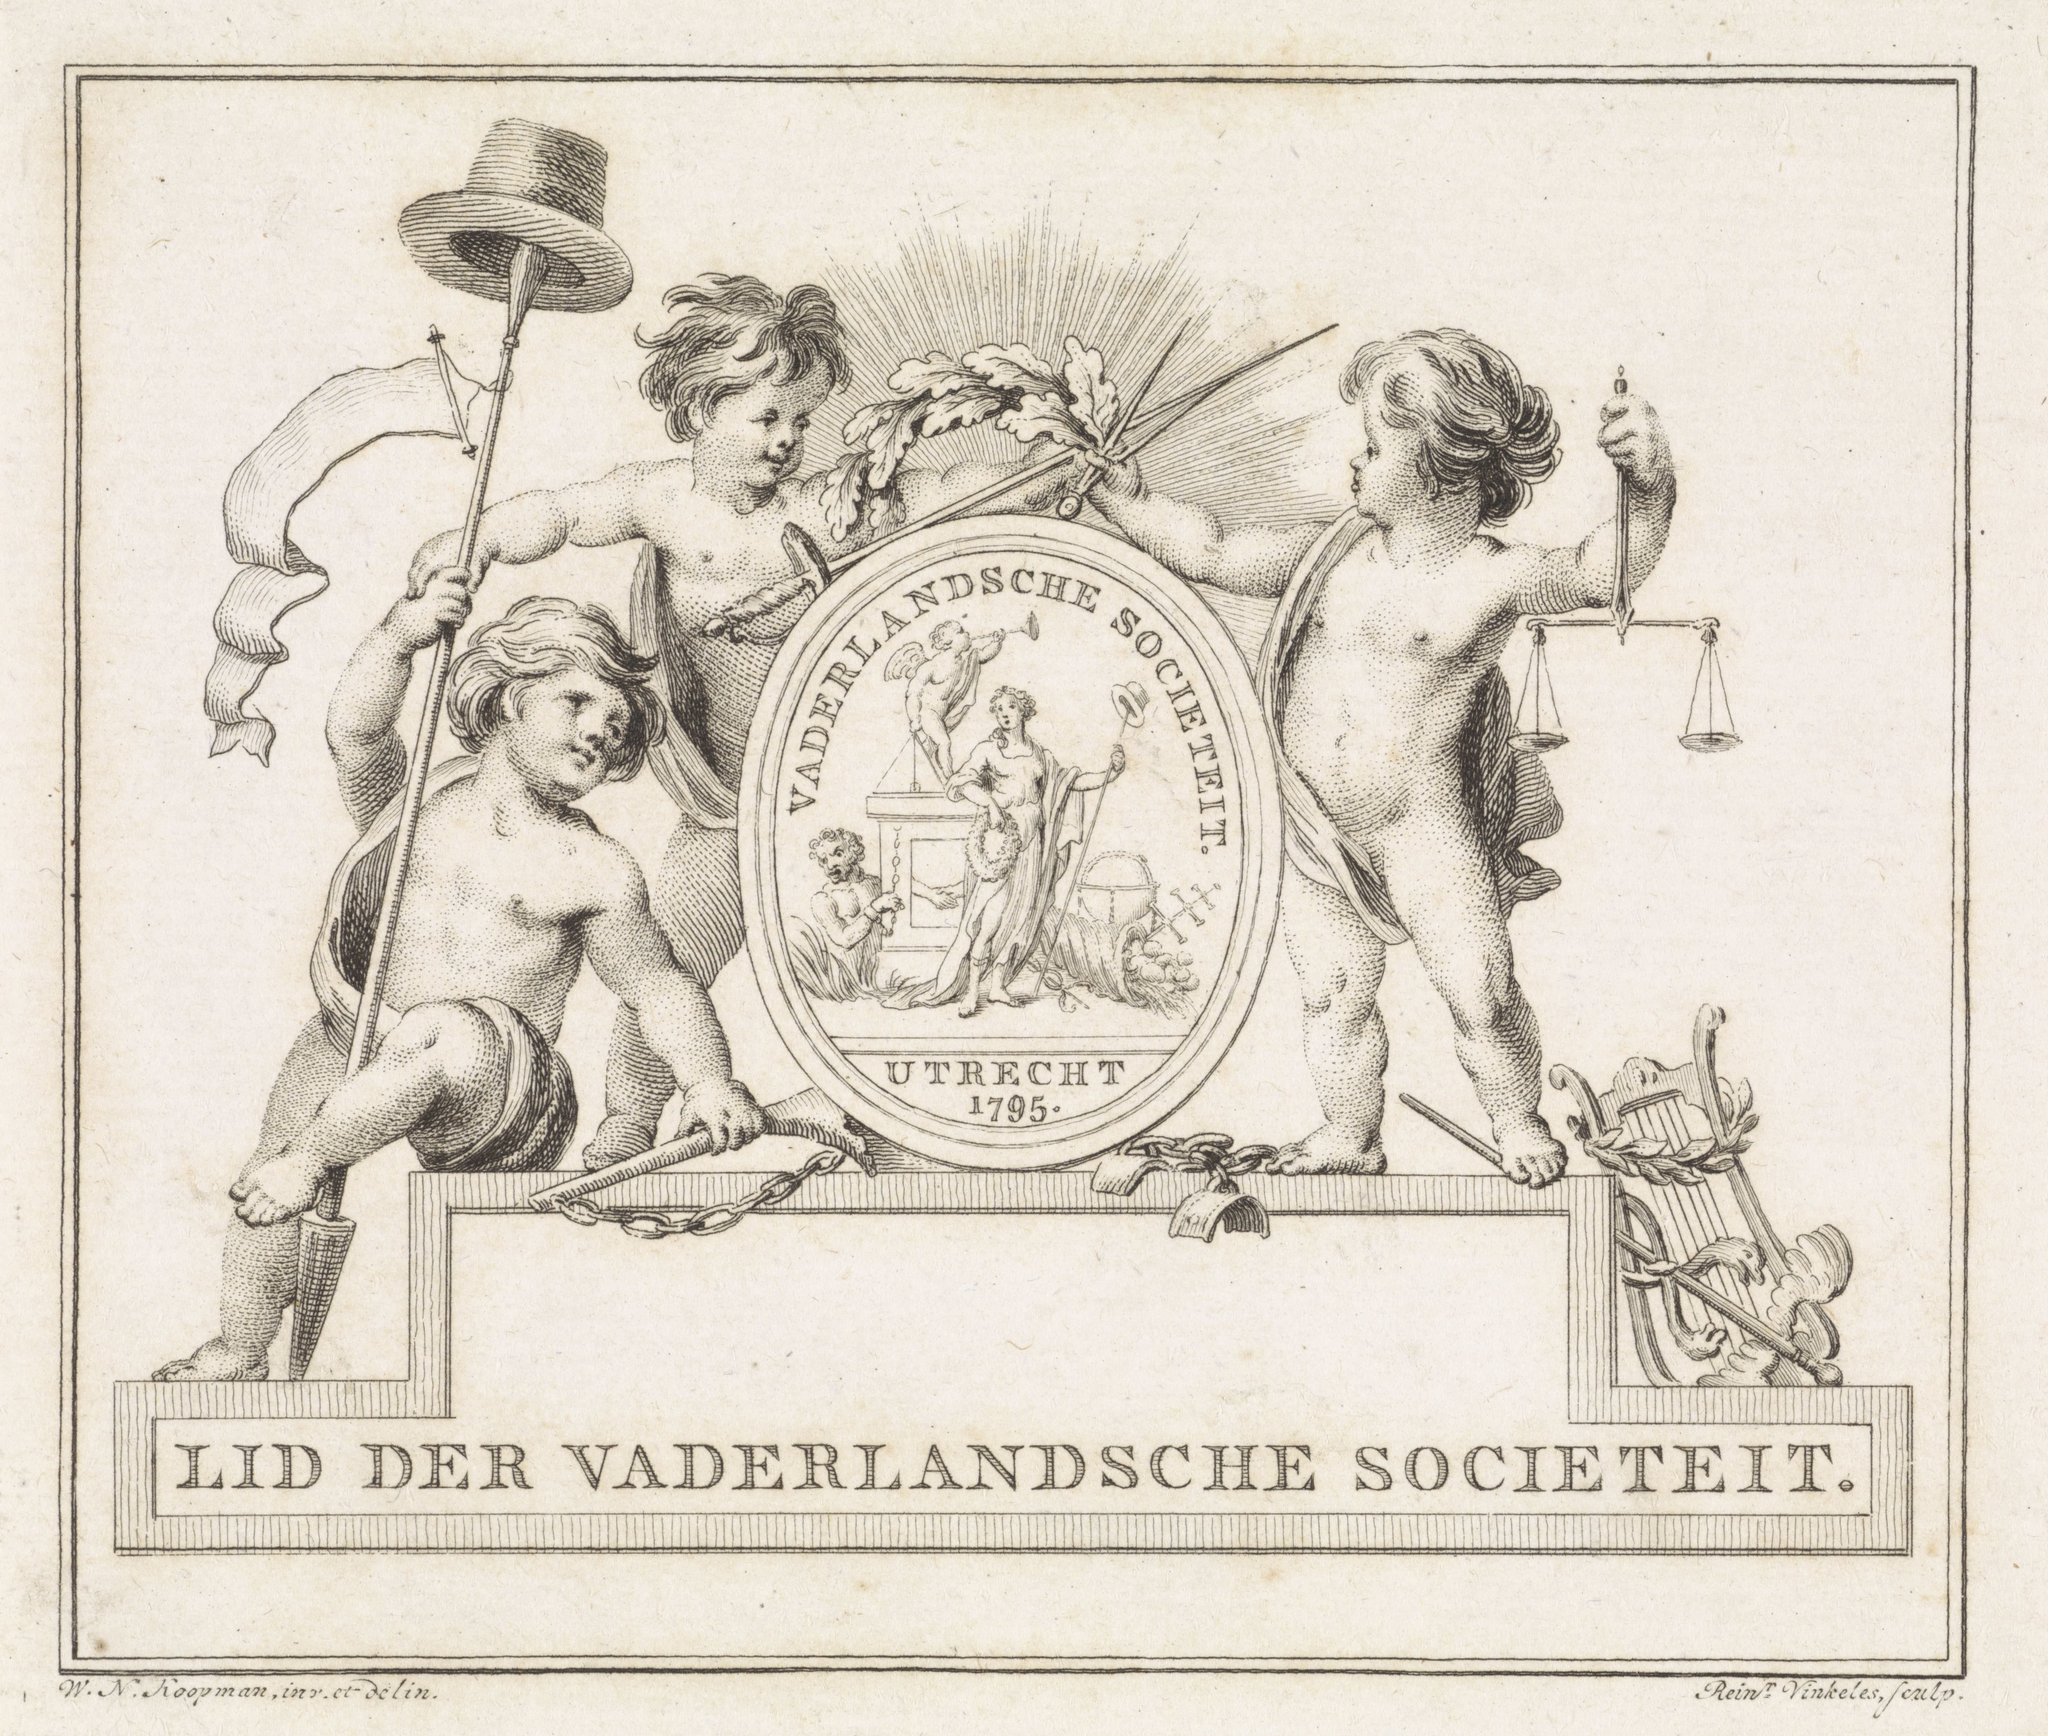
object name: print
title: Lid der Vaderlandsche Societeit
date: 1795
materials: paper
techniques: engraving, etching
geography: amsterdam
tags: cupids: 'amores', 'amoretti', 'putti', freedom, liberty; 'libertà' (ripa) (+ symbolical representation of concept)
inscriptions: collector's mark: Lugt 240